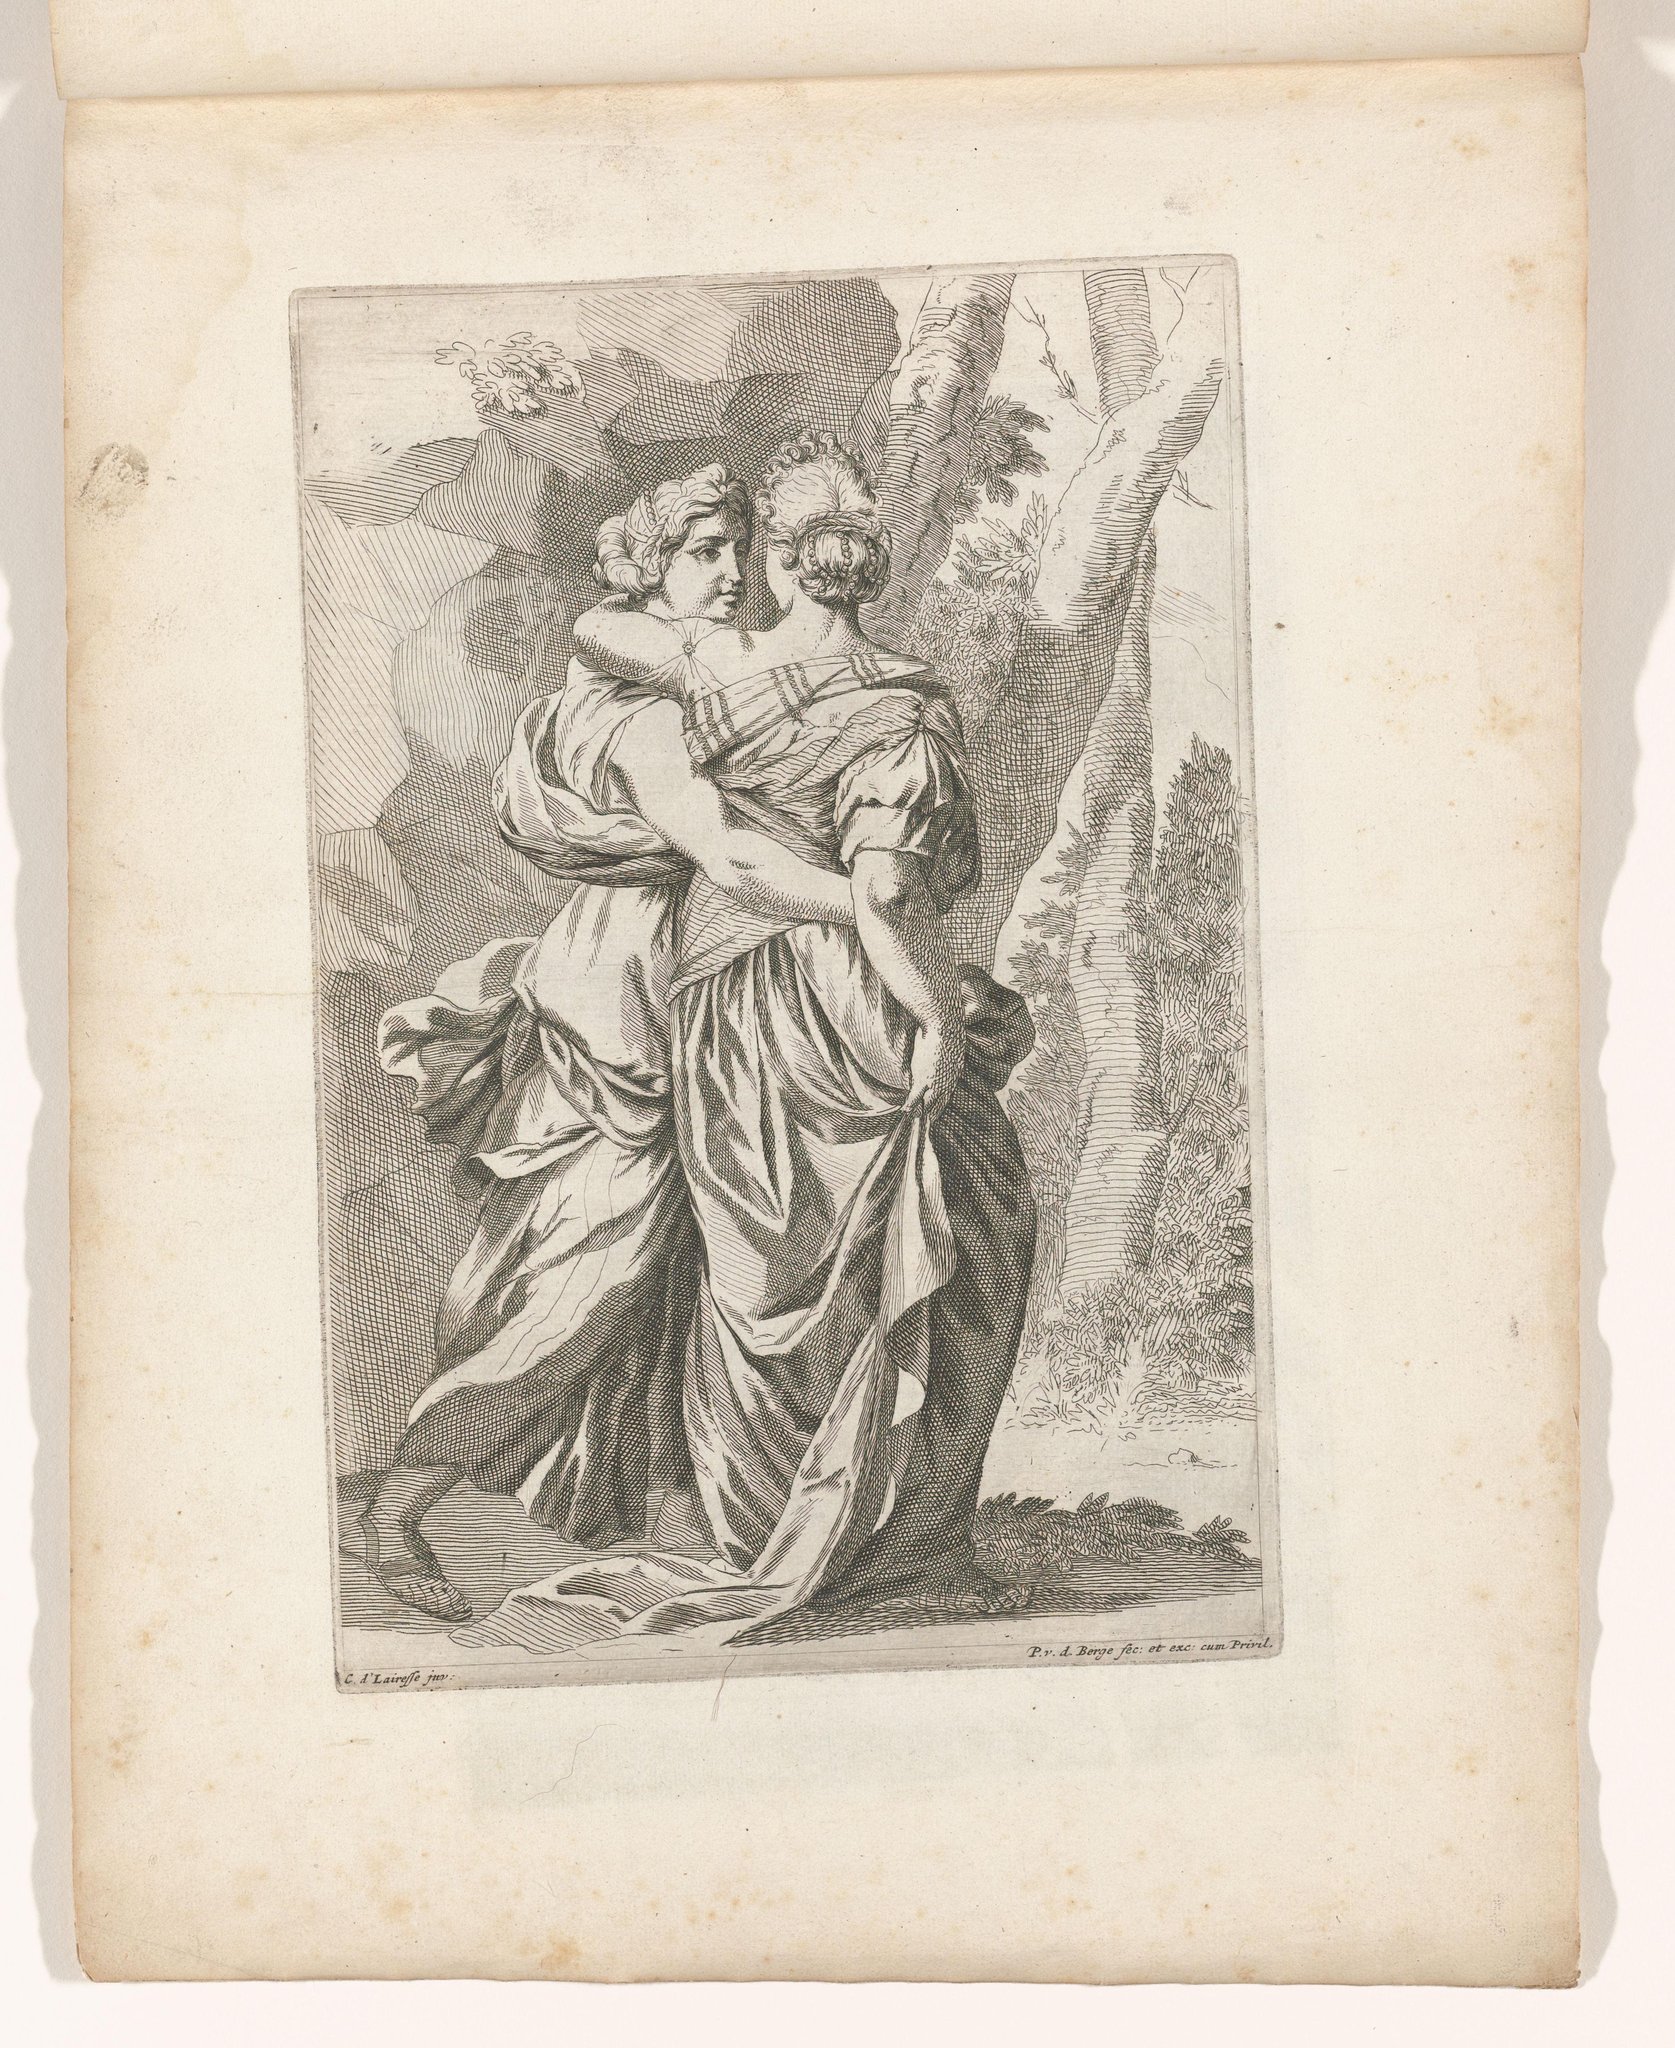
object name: print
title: Prent 8 uit serie tekenvoorbeelden met twee gearmde vrouwen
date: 1695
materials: paper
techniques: etching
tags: adult woman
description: Prentserie van elf bladen met tekenvoorbeelden naar Gerard de Lairesse en een titelblad gebonden in een eigentijds(?) omslag. Elf prenten met voorbeelden van gezichten, mythologische en andere figuren, ornamenten en architectuur.